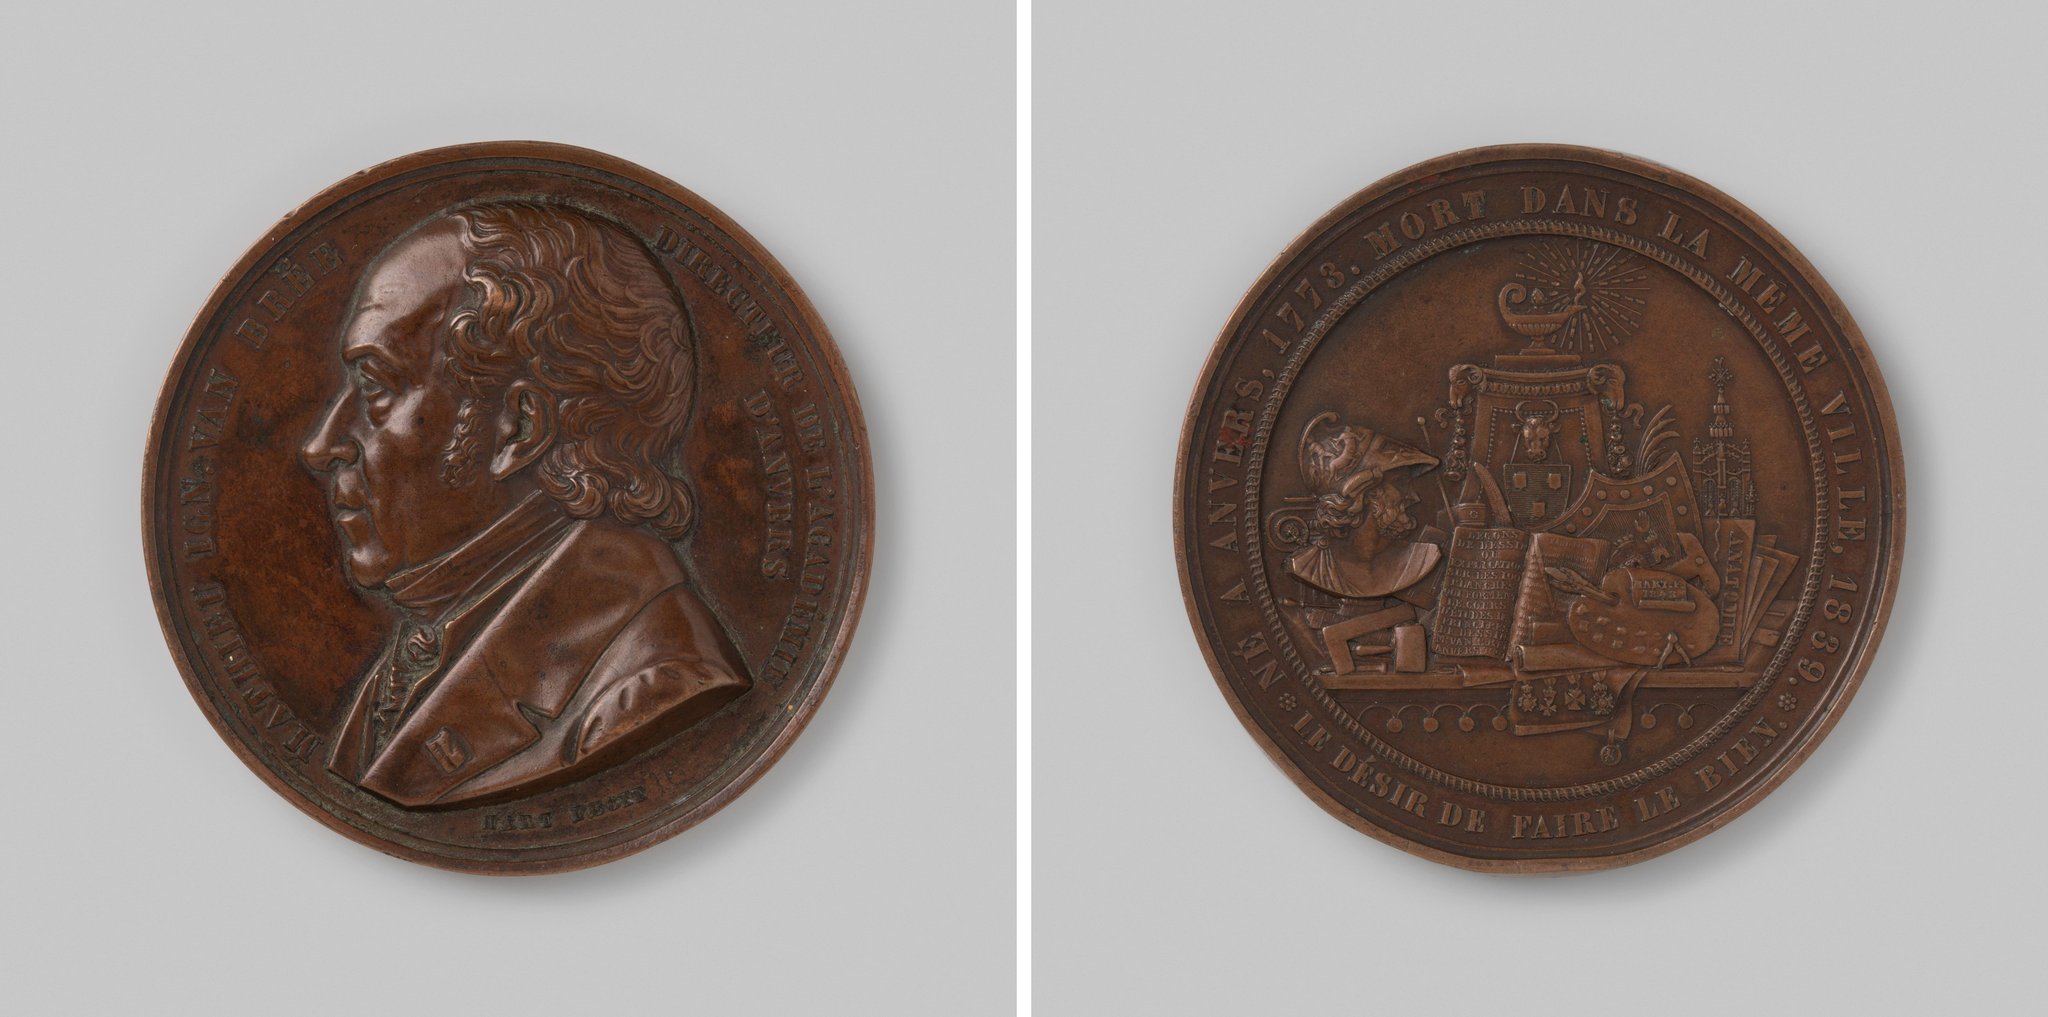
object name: medal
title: Matthieu Ign. van Bree, Directeur de l'Académie d'Anvers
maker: laurent joseph hart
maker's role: die cutter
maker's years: 1810-1860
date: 1843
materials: bronze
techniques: casting, riveted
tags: antwerp, draughtsman, mattheus ignatius van bree, schools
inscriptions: circumscription: ‘Ne en Anvers, 1773, mort dans la meme ville, 1839 / Le Desir de Faire le Bien’, circumscription: ‘Matthieu Ign. van Bree / Directeur de l'Academie d'Anvers’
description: Bronzen penning, gegoten en geklonken, gemaakt naar aanleiding van het overlijden van de schilder M.I. van Bree (1773-1839). Voorzijde: buste van naar links gekeerde, en profil weergegeven man, met omschrift. Keerzijde: op piedestal gegroepeerde voorwerpen die op kunst en kunstbeoefening betrekking hebben, waaronder een buste van een Griekse god, een schilderspalet en boeken, alsmede enkele oorkondes, met op achtergrond een altaar waarop een brandend olielampje, binnen koorden rand waarom omschrift.